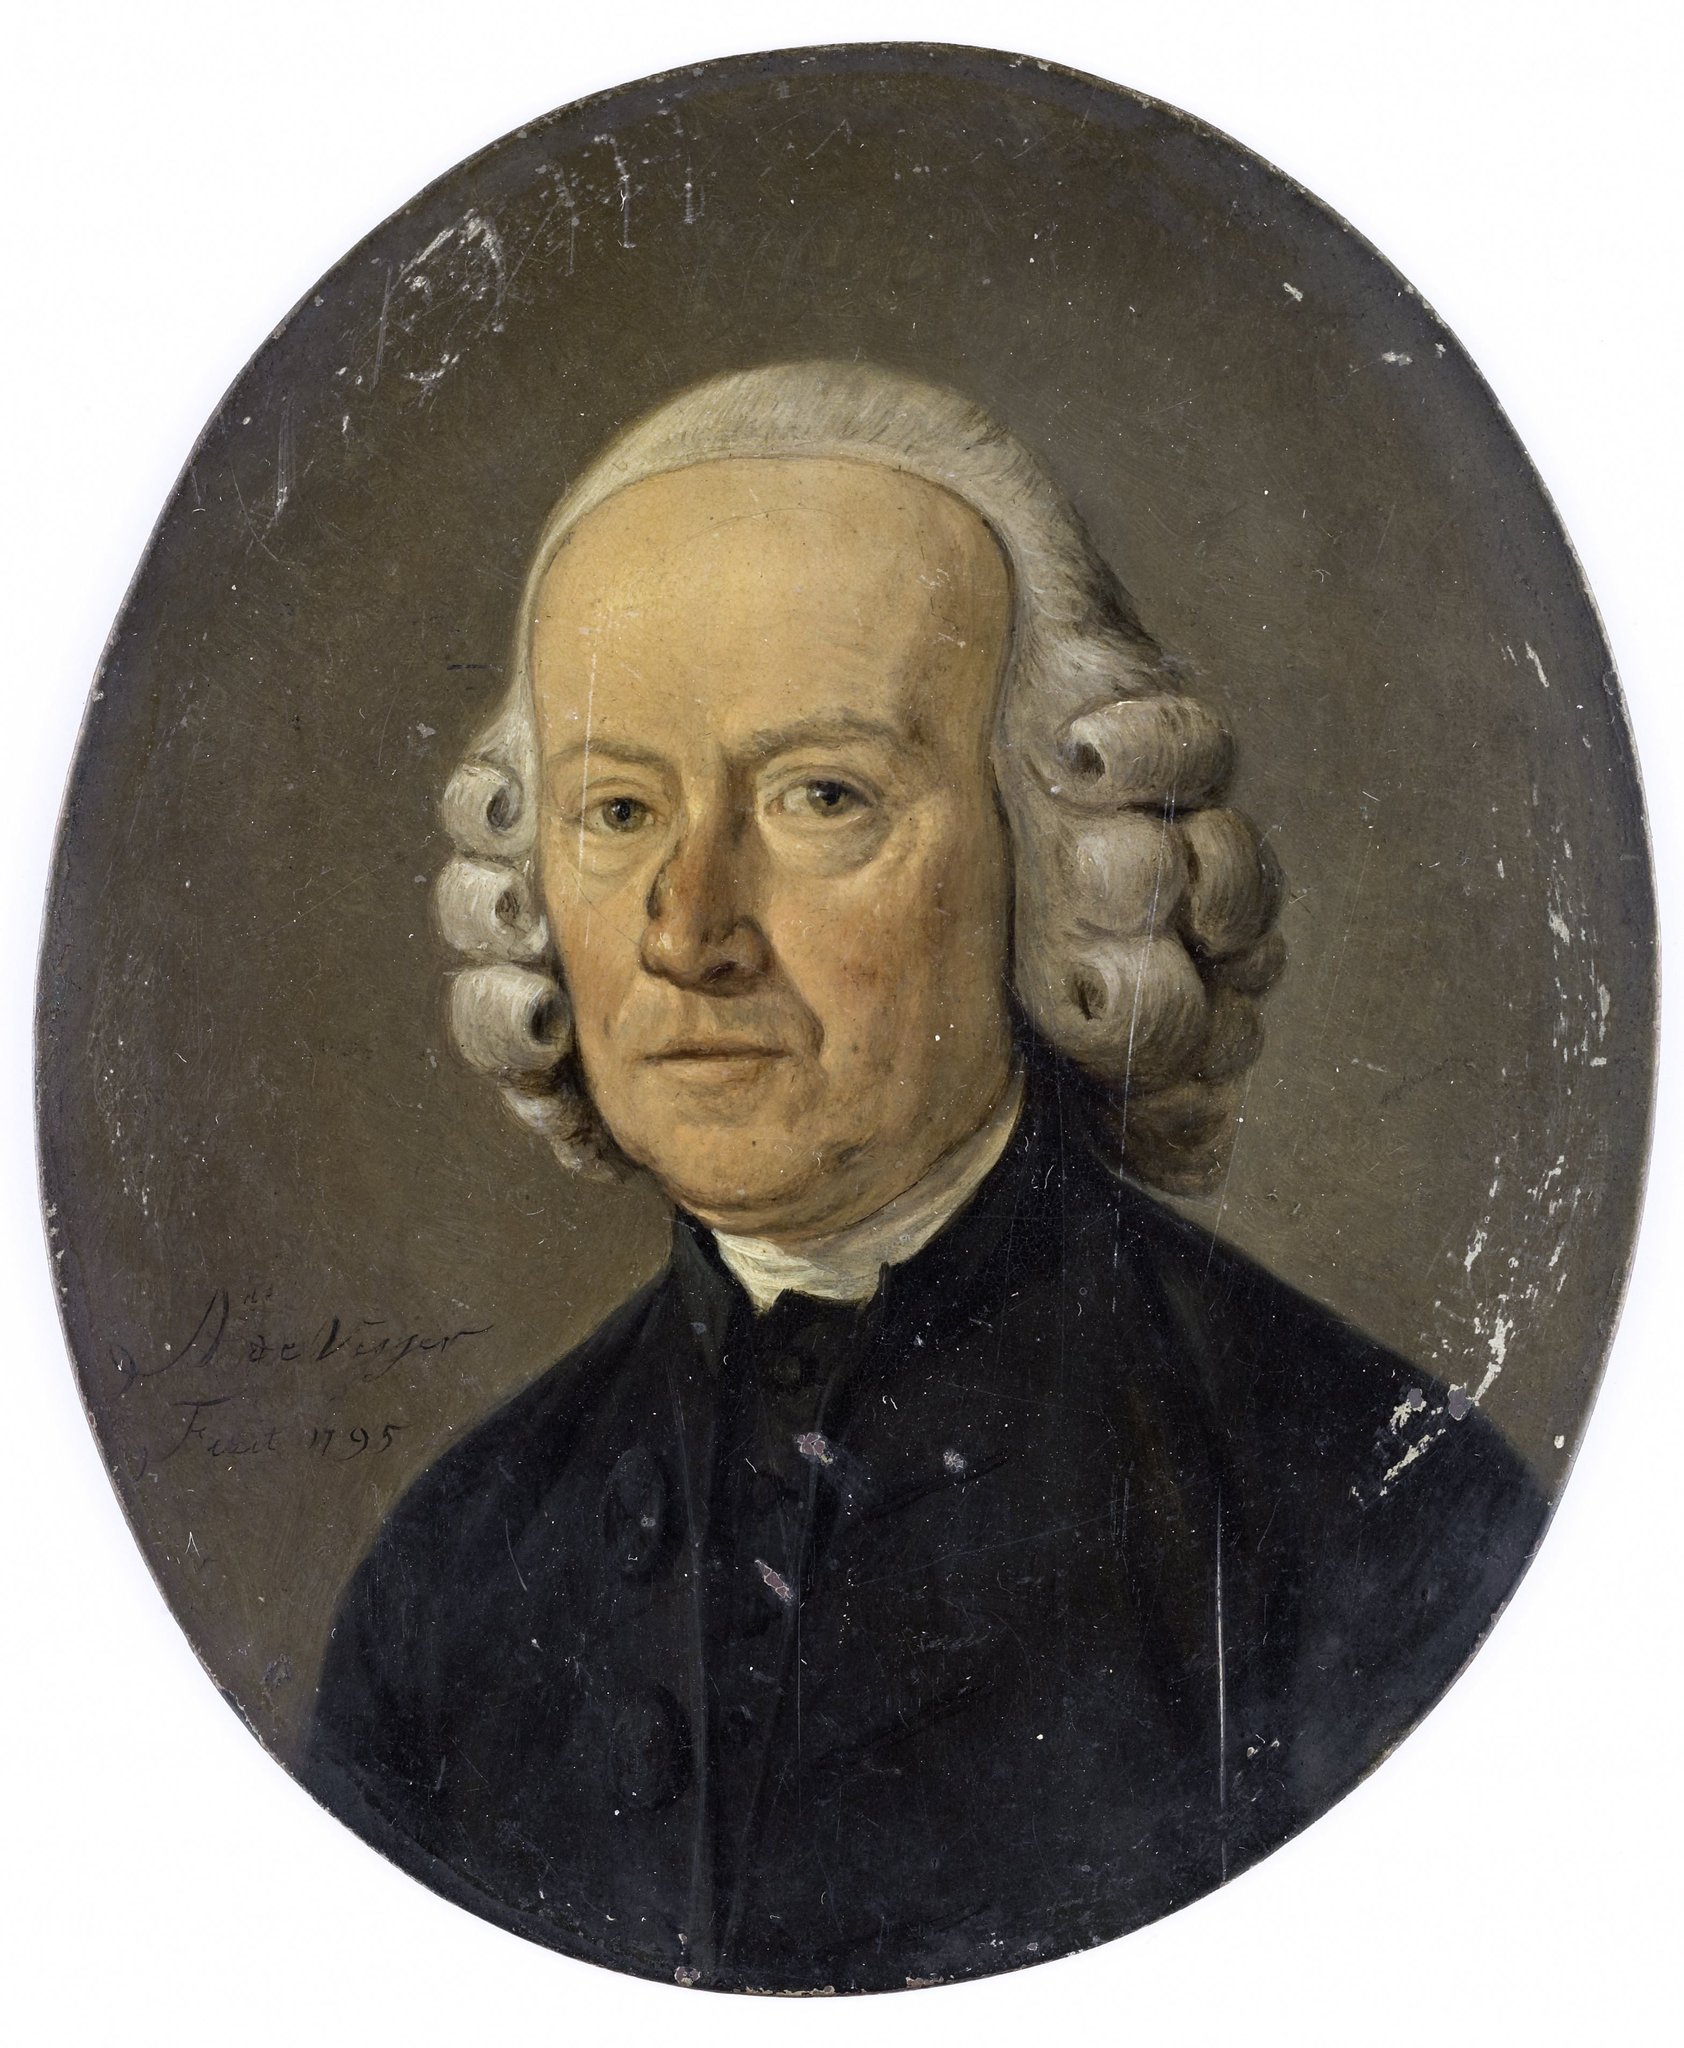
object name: painting, miniature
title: Portret van een man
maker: adrianus de visser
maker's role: draughtsman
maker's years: 1762-1837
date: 1795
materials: copper, glass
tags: anonymous historical person portrayed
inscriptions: signature and date: ‘A. de Visser Fecit 1795’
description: Portret van een man. Buste naar links, aanziend. Onderdeel van de collectie portretminiaturen.